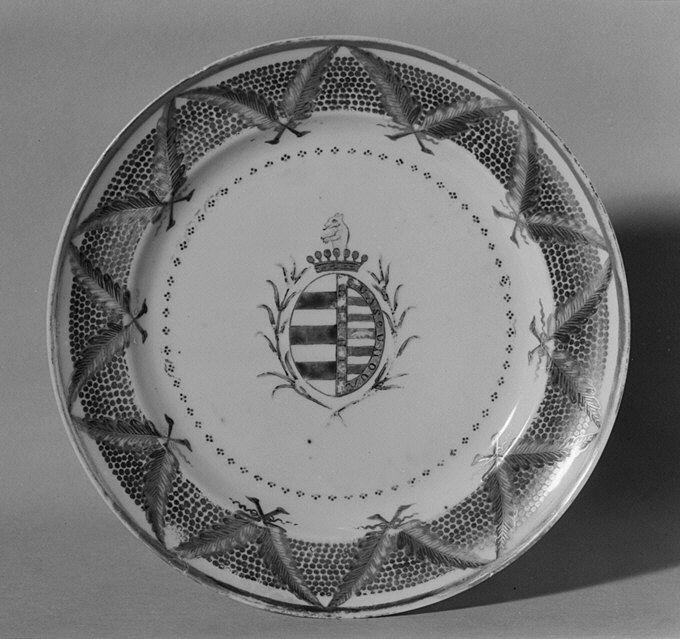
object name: plate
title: Plate (part of a service)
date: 1810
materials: hard paste porcelain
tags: feathers,insignia